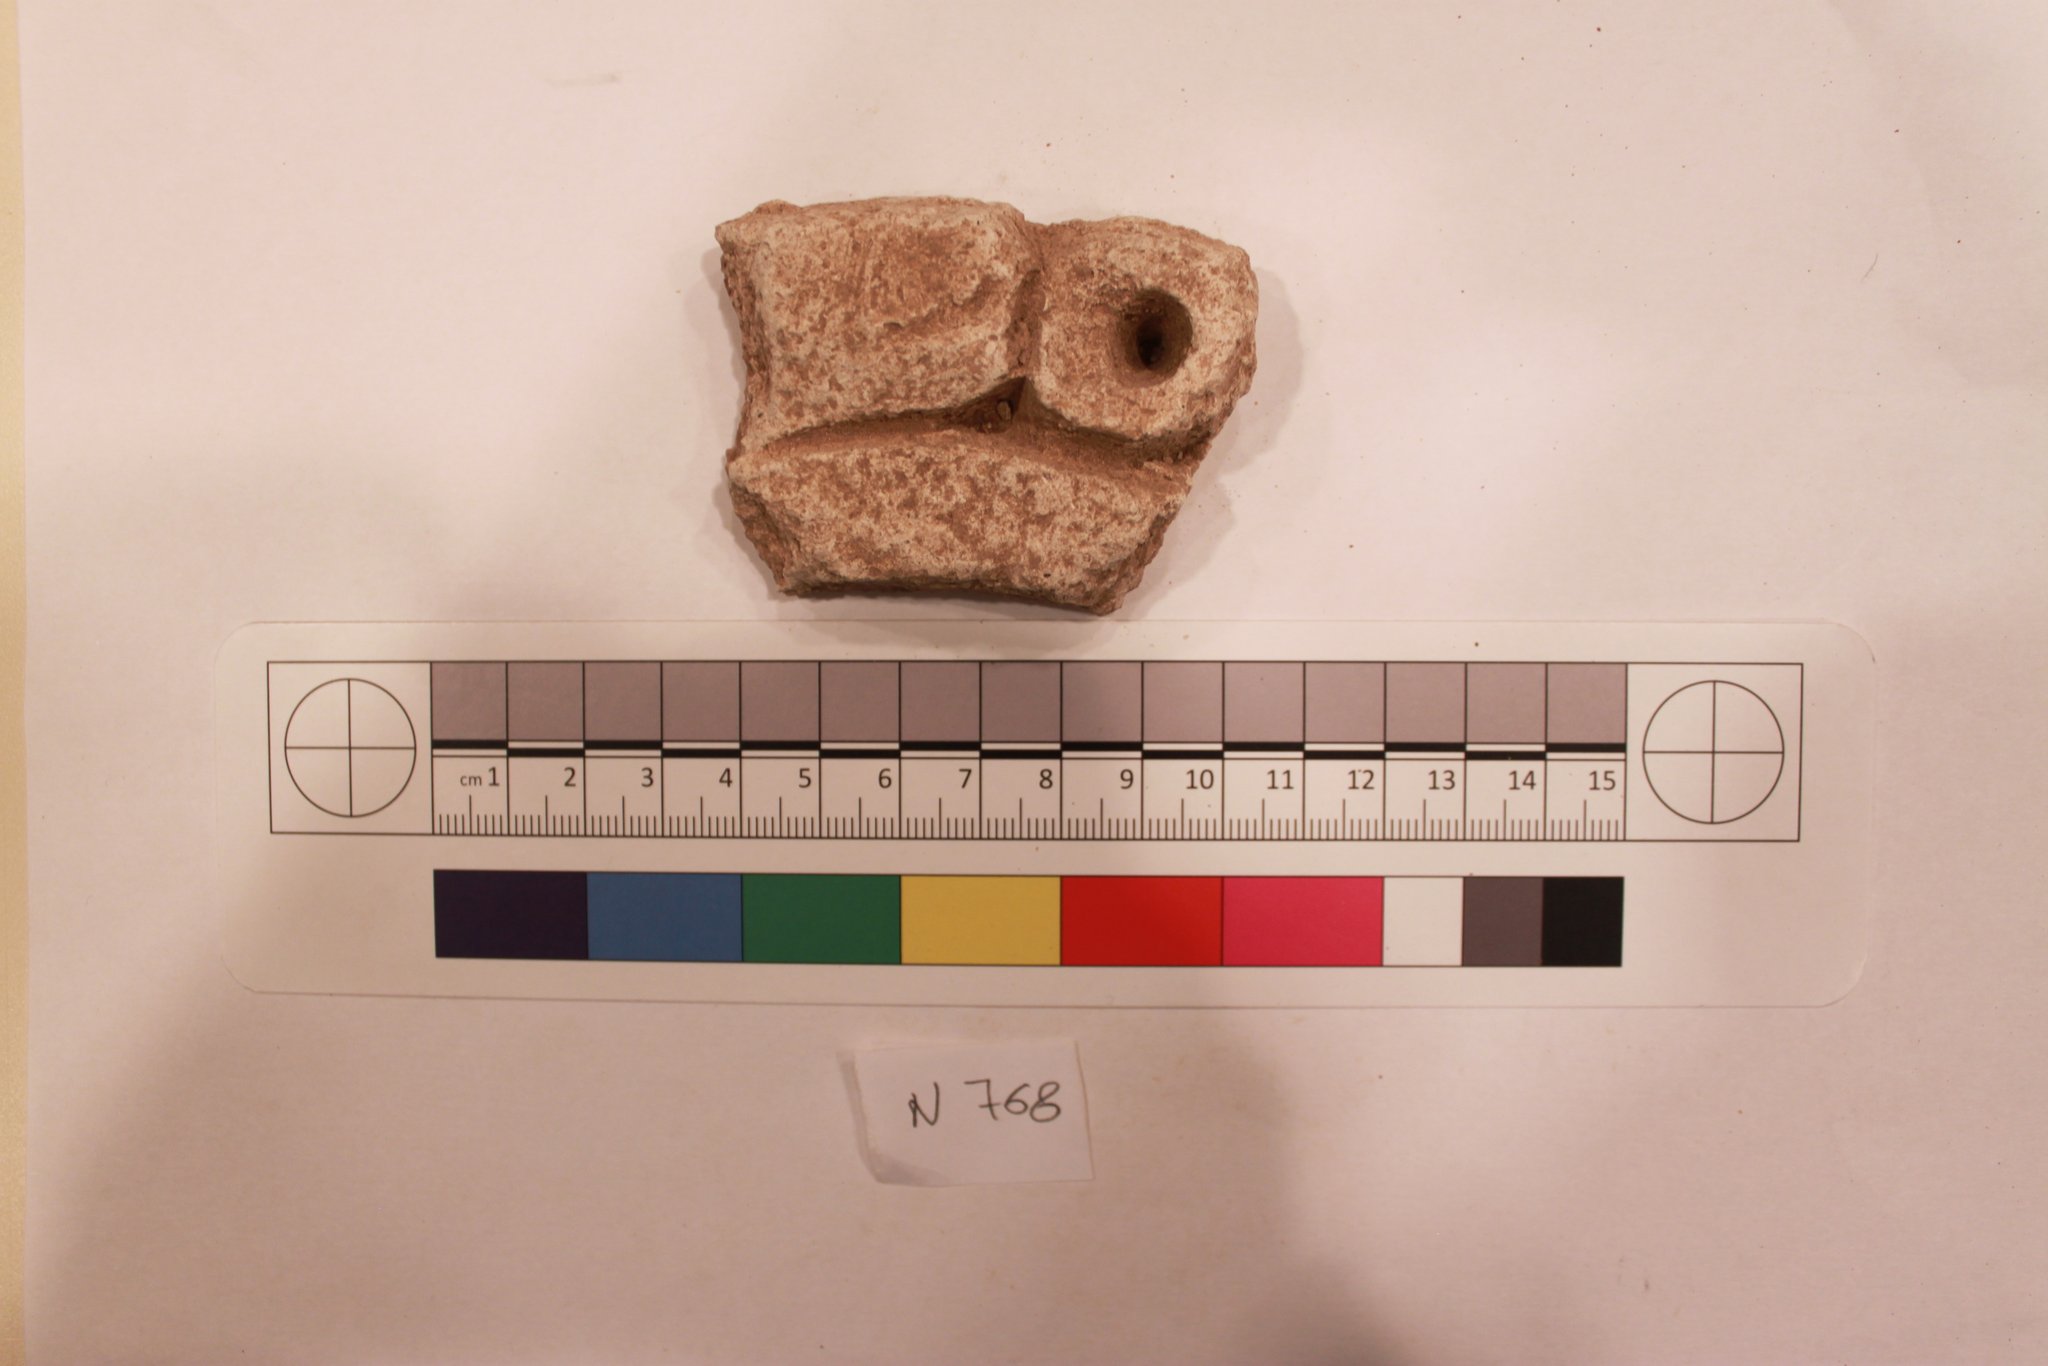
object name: fragment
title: Stucco Fragment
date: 701-1200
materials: plaster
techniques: carving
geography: iran